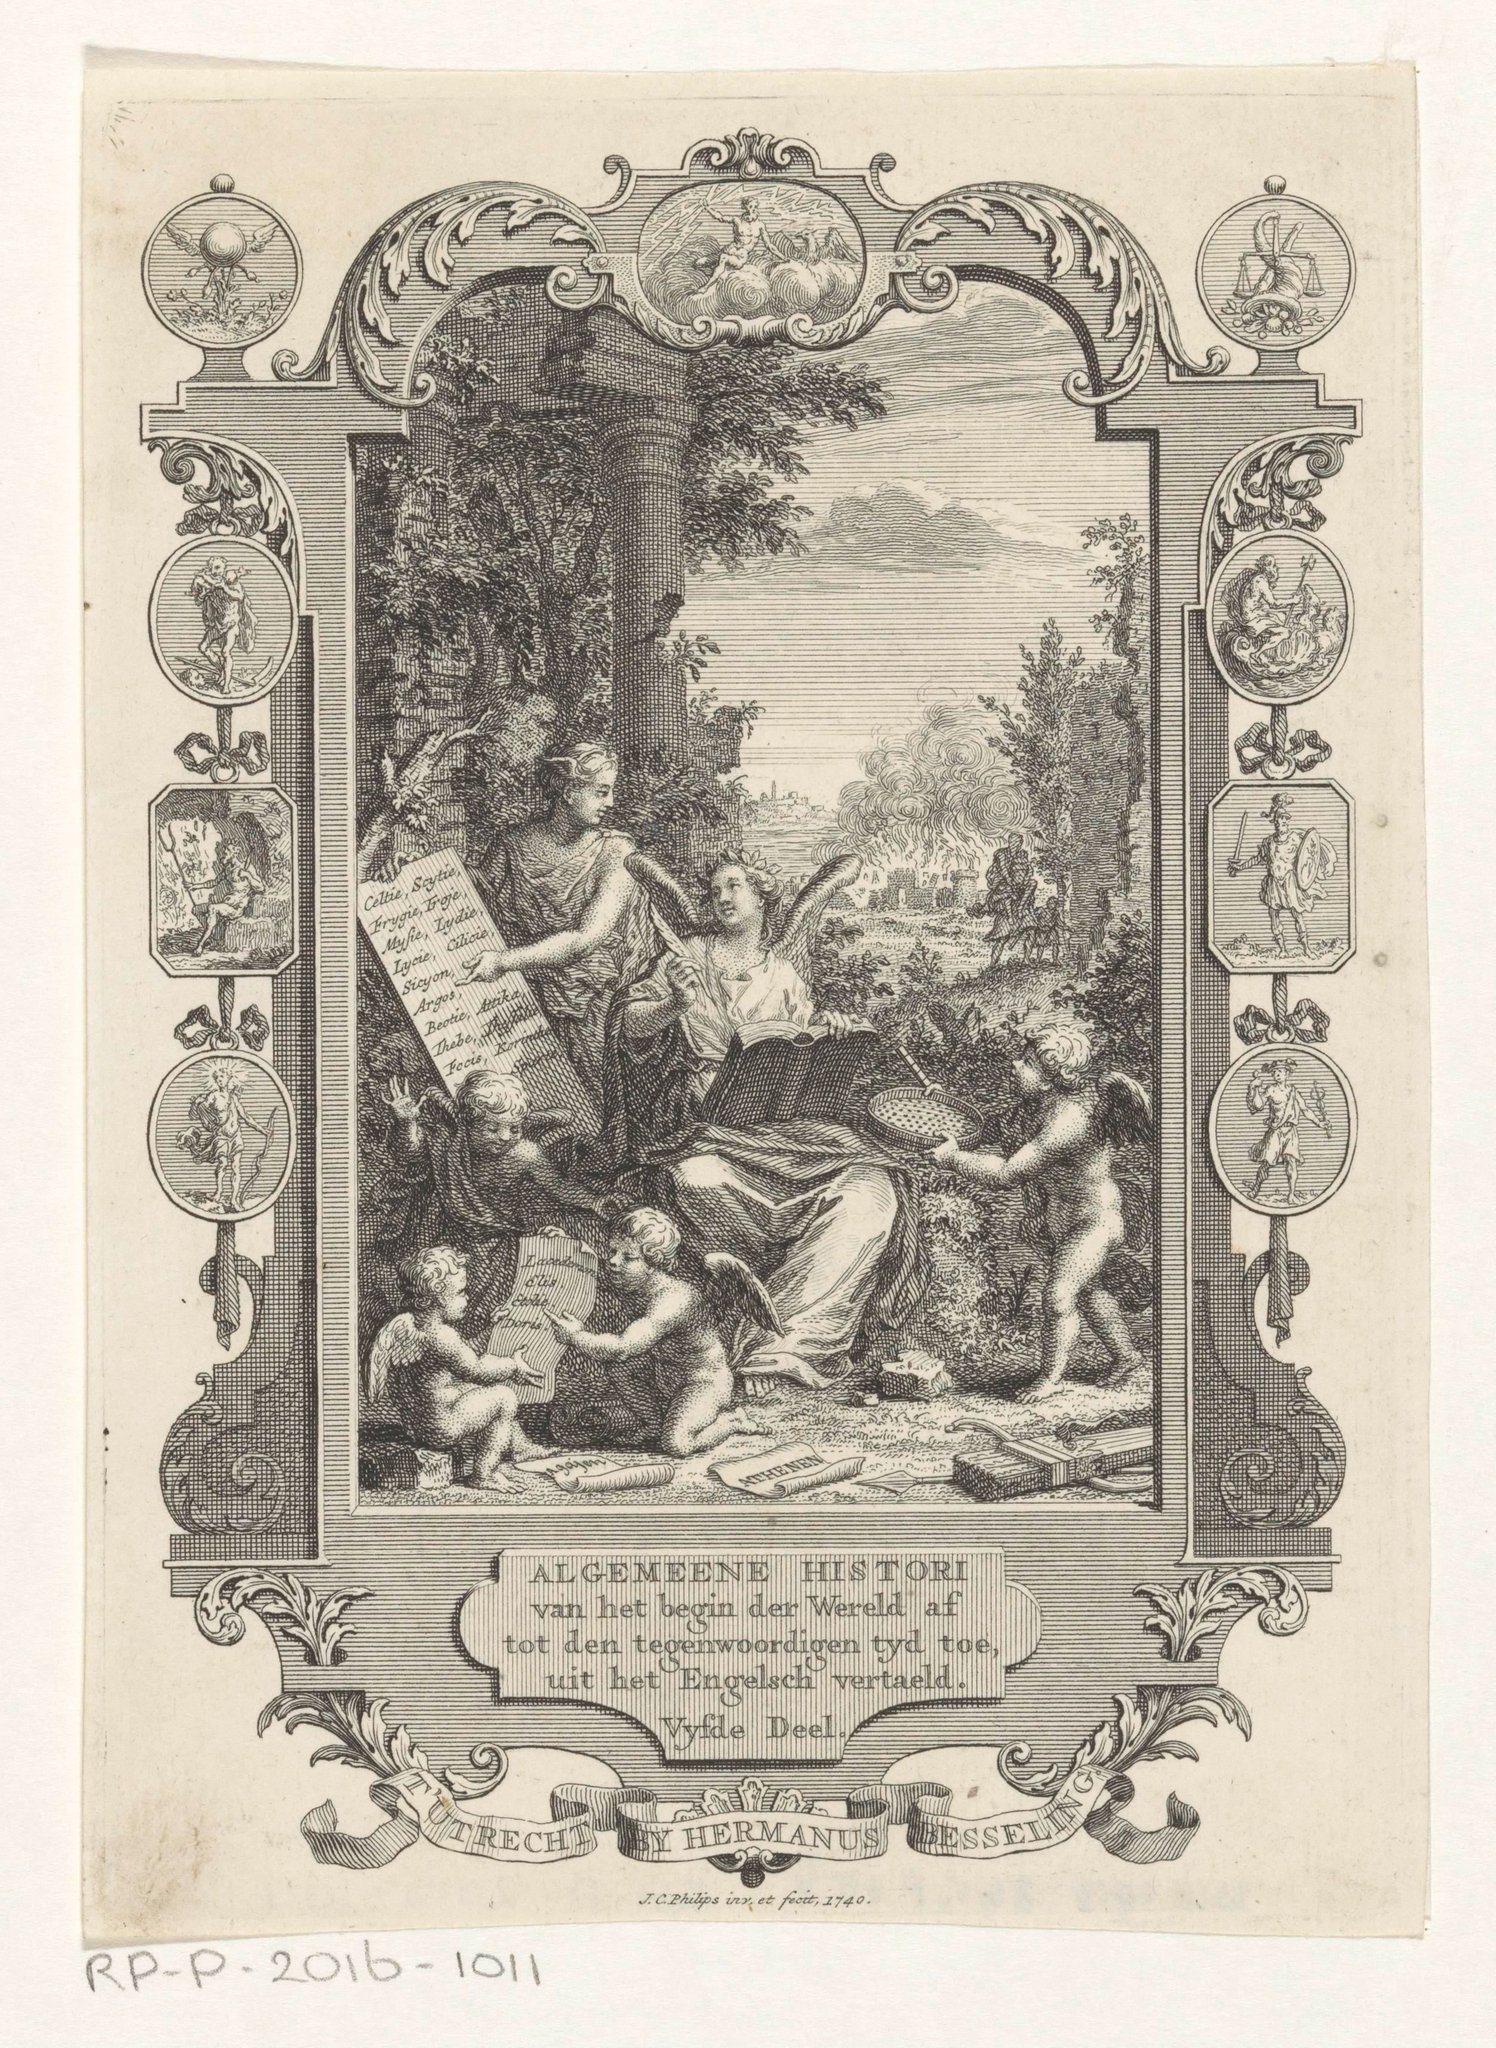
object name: print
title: Titelpagina voor: Kornelis Westerbaen, Algemeene histori, 1740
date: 1740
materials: paper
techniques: engraving, etching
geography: utrecht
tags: the olympian gods together: jupiter, juno, neptune, ceres, apollo, diana, mars, venus, mercury, minerva, vulcan, vesta (or bacchus), 'pius aeneas': aeneas, leading ascanius, escapes from burning troy, carrying his father anchises with the penates; his wife creusa, who sets out with them, is lost on the way, 'historia'; 'historia' (ripa), the greek heroic legends (i)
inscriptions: collector's mark: Lugt 2228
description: Titelpagina voor: Westerbaen, Kornelis. Algemeene histori van het begin der Wereld af tot den tegenwoordigen tyd toe, Vyfde Deel. Utrecht: Besseling, Hermanus, 1740. Prent afkomstig uit een plakalbum met titelprenten, ornamenten etc. op blauw papier in 1983 uit elkaar gehaald. Volgens een notitie op verso zat de prent op p. 106 van dit album.